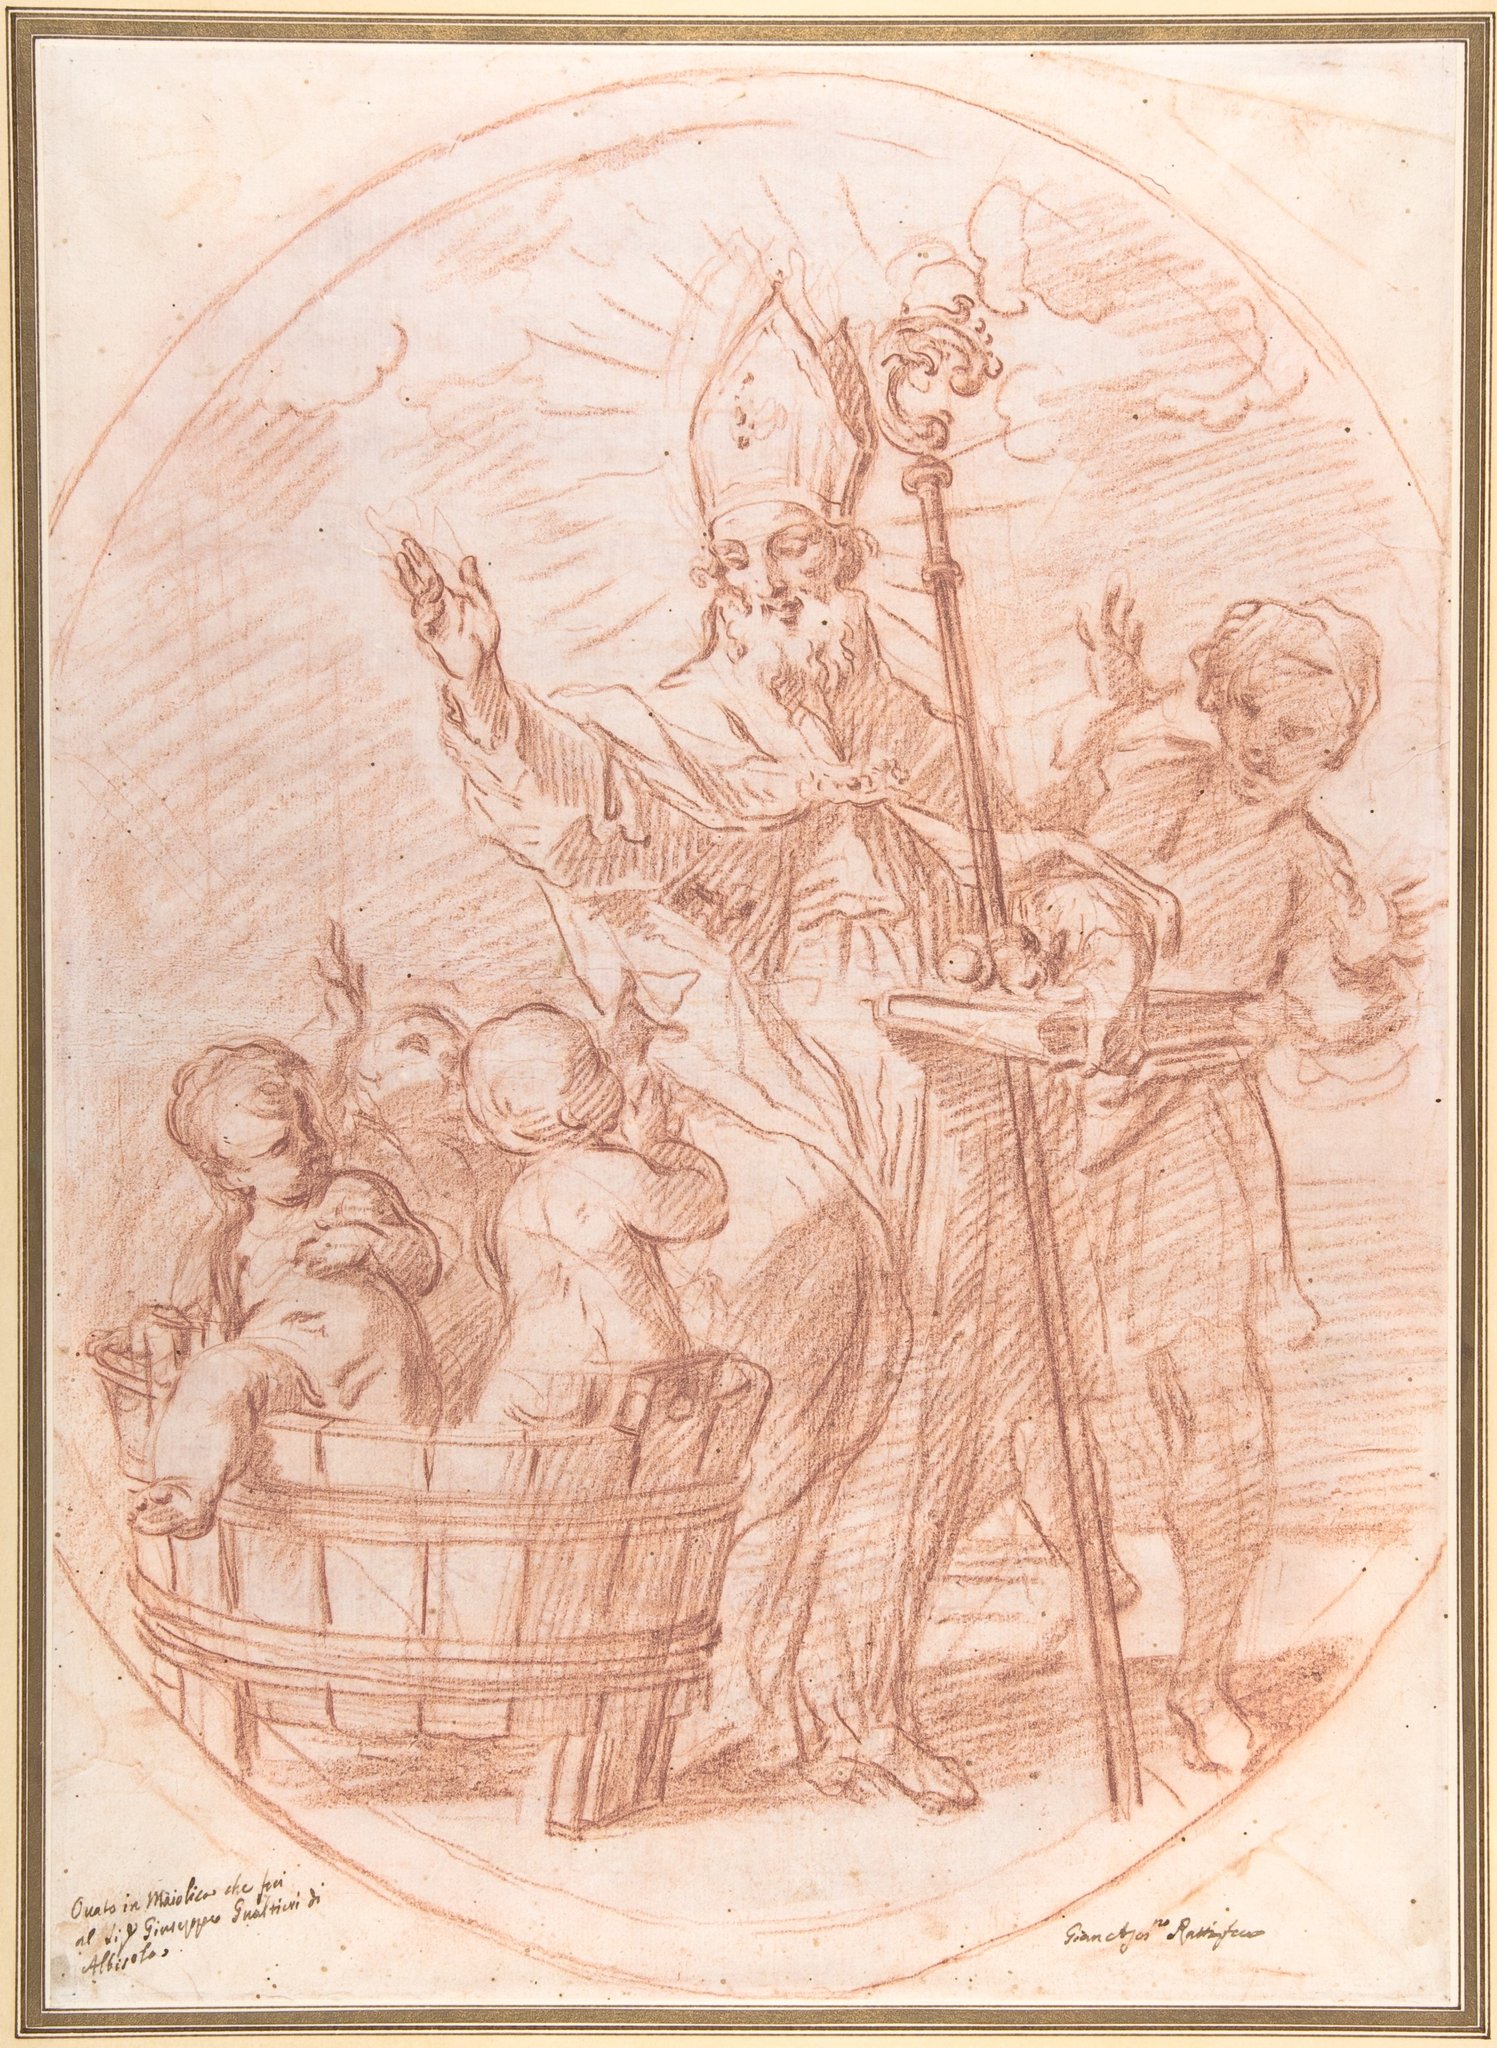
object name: drawing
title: Saint Nicholas of Bari Resuscitating Three Children Discovered in a Tub of Brine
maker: giovanni agostino ratti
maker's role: artist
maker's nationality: italian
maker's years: 1699-1795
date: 1699-1795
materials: chalk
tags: children,saints